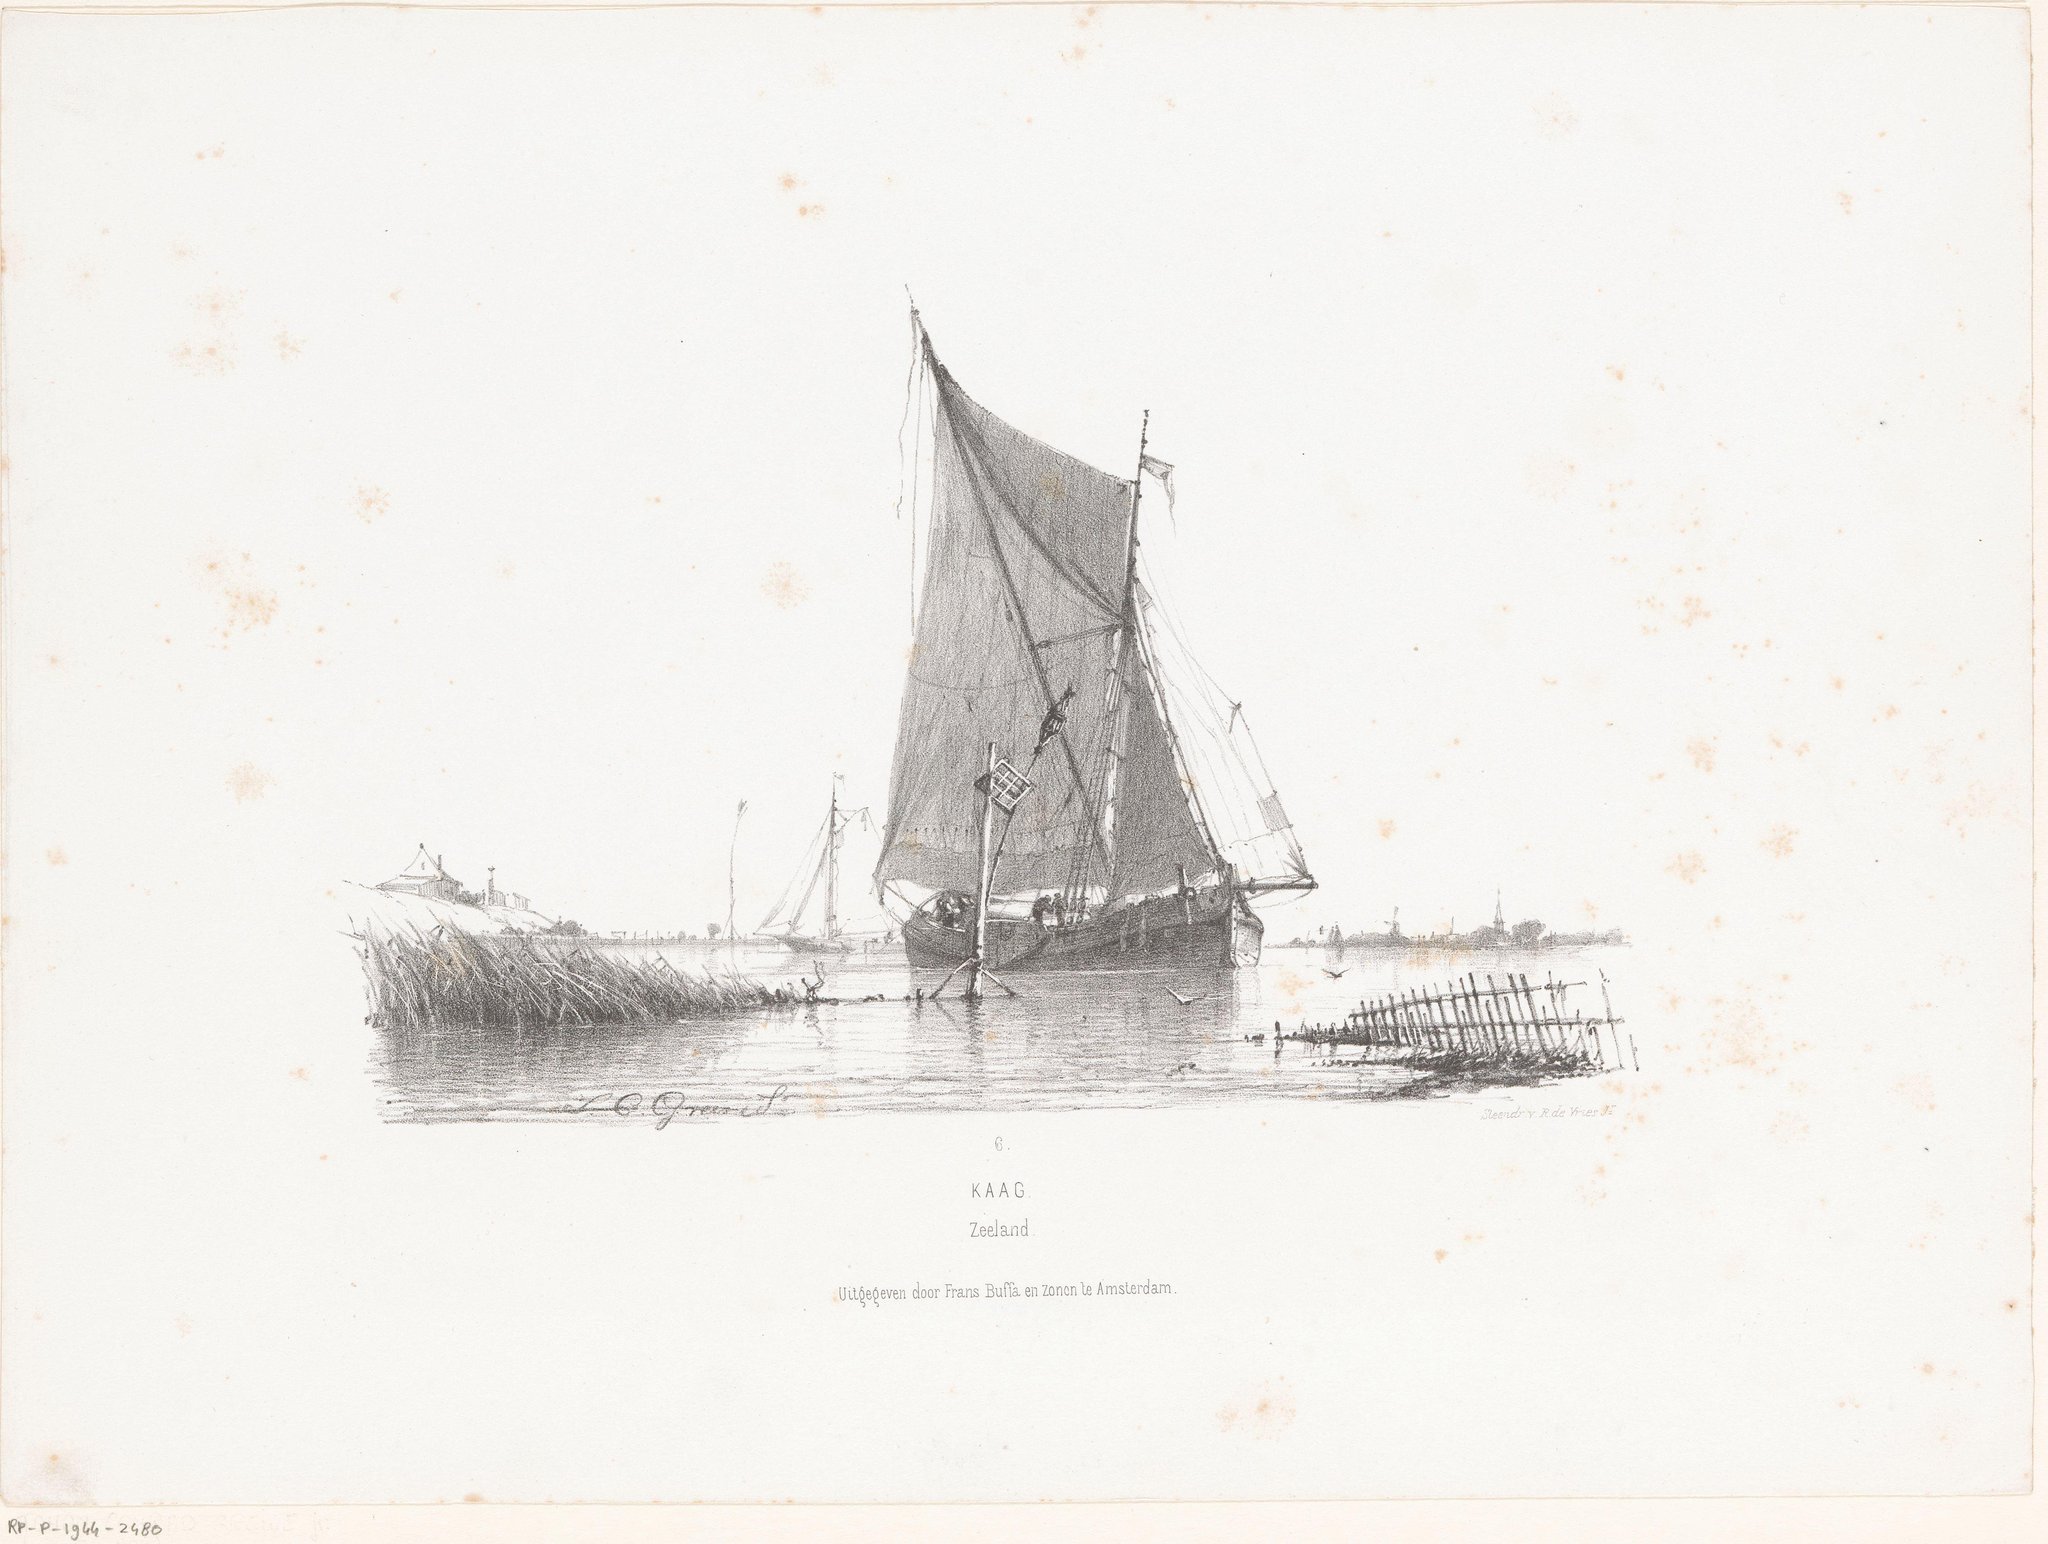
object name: print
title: Kaag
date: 1860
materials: paper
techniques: lithograph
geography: netherlands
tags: sailing-ship, sailing-boat, prospect of city, town panorama, silhouette of city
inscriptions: collector's mark: Lugt 2228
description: Prent uit een twaalfdelige serie, getiteld 'Studiën van Hollandsche Schepen naar de Natuur geteekend en op Steen gebracht door J.C. Greive Jr., uitgegeven door Frans Buffa en Zonen in Amsterdam.